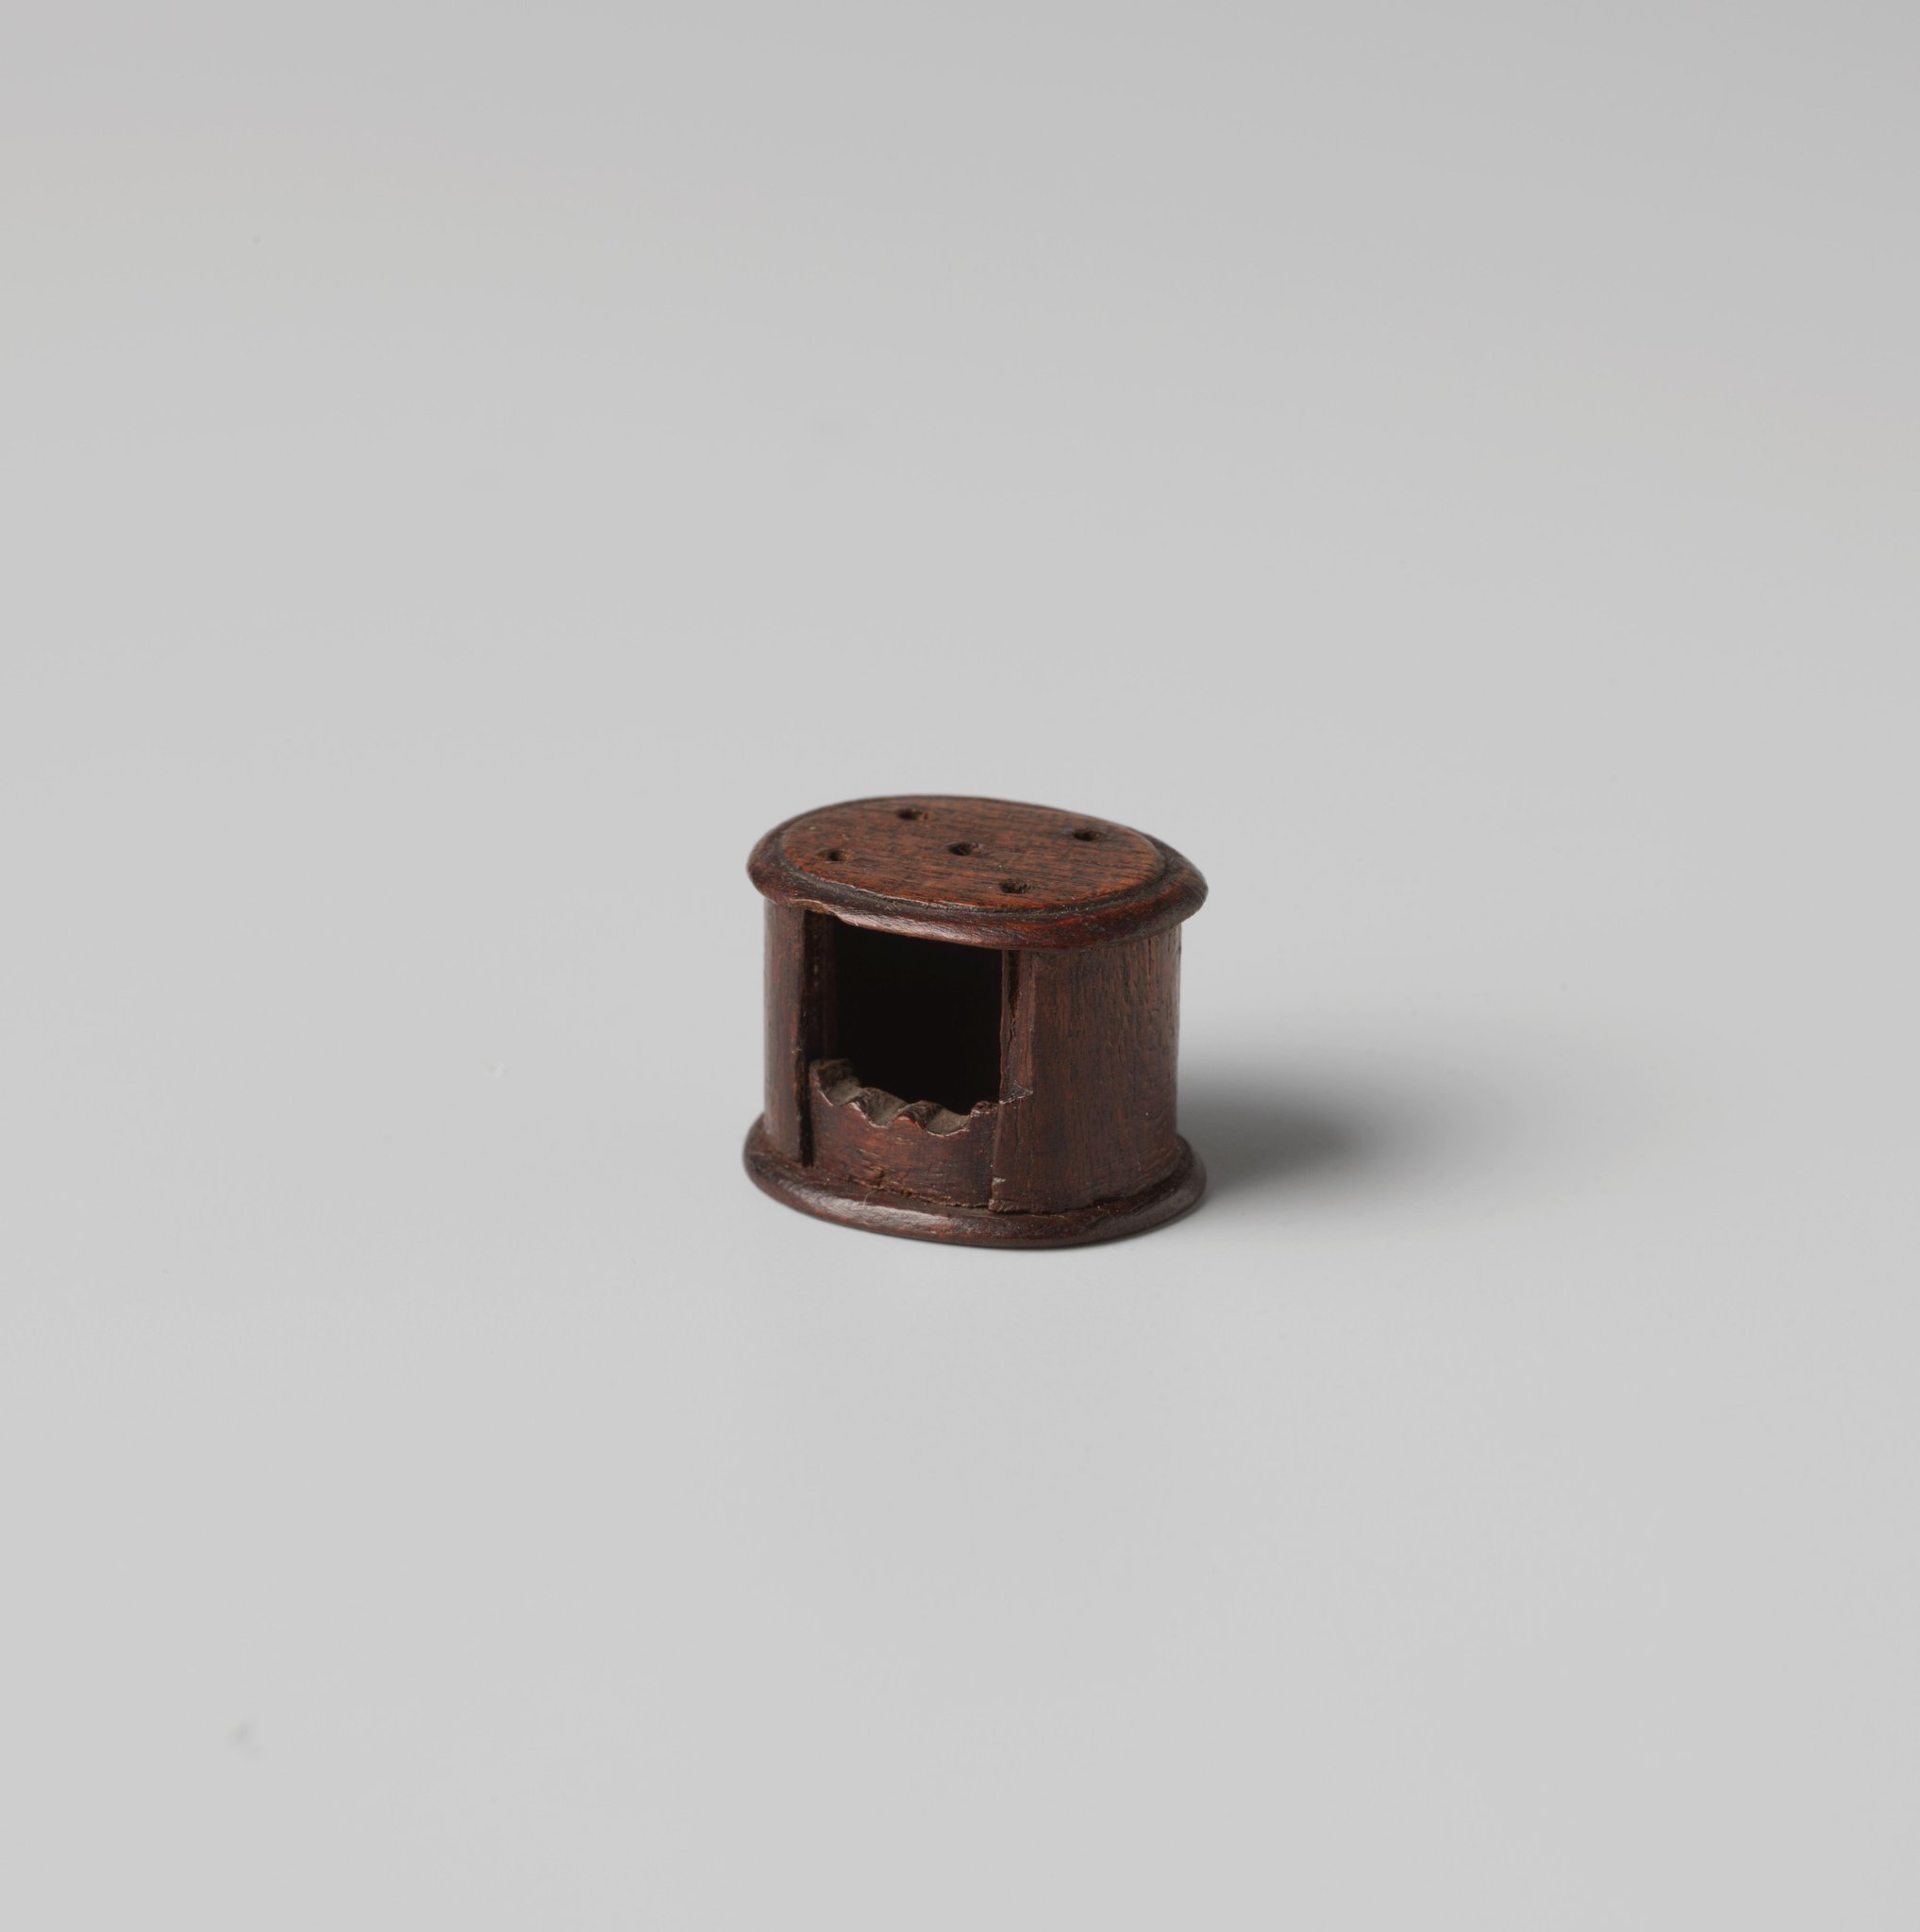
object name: miniature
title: Stoof, ovaal, met vijf gaten in de bovenzijde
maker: Anonymous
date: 1740-1760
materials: wood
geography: amsterdam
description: Stoof van mahoniehout, ovaal, met in de bovenzijde vijf gaten.